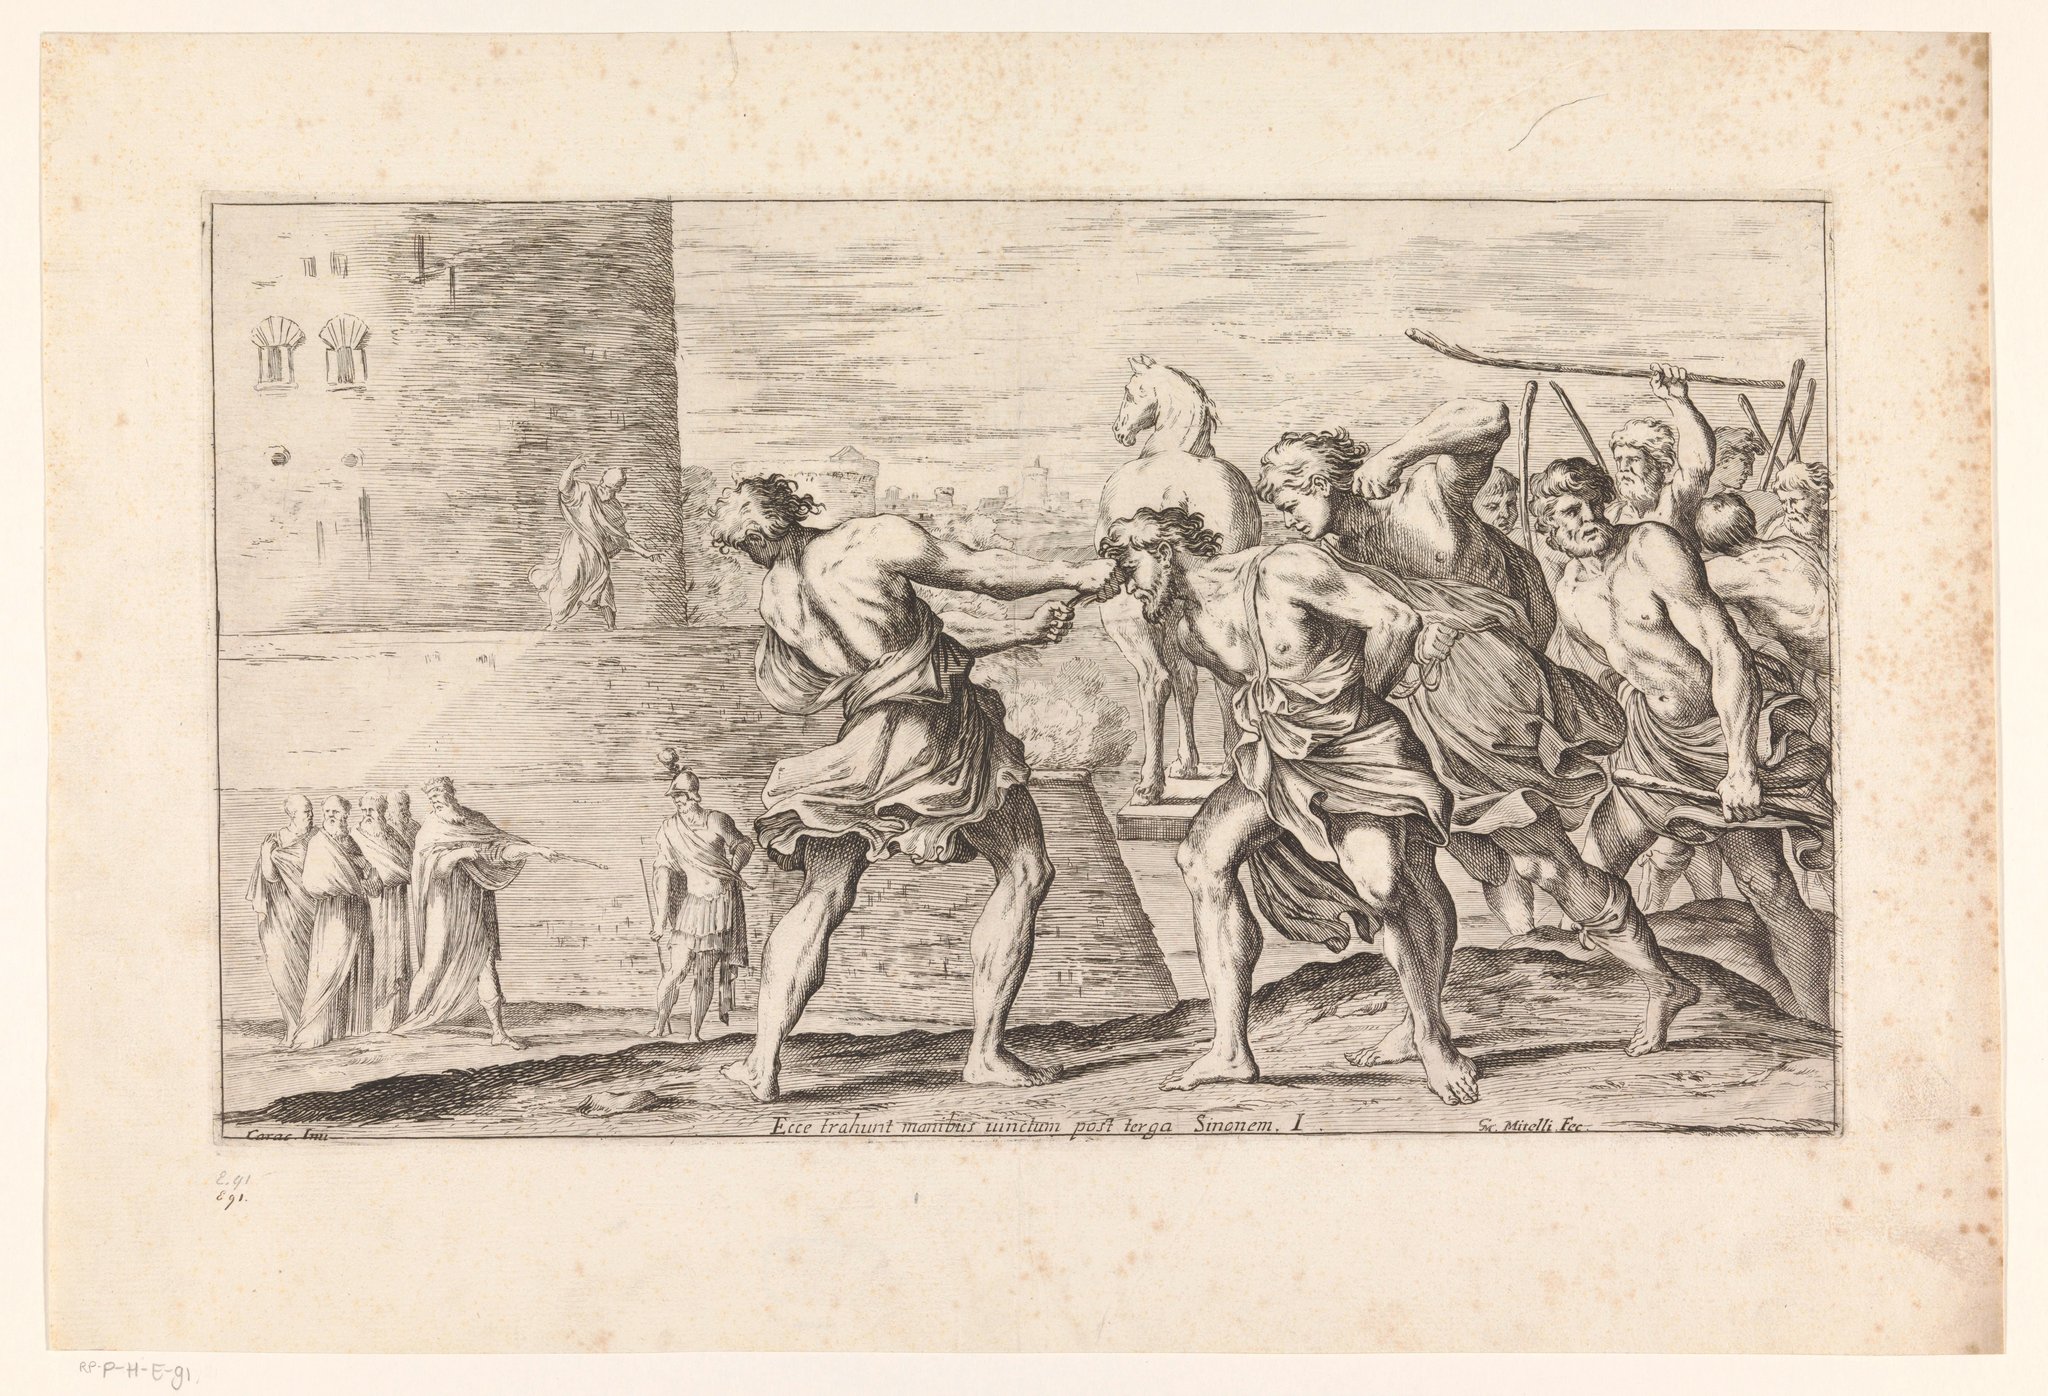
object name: print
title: Omzwervingen van Aeneas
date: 1663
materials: paper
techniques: etching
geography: rome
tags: (story of) aeneas, sinon, a greek pretending to be a deserter, is brought in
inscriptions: collector's mark: ‘Hinloopen’, collector's mark: Lugt 11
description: Deze prent maakt deel uit van een reeks van 20 prenten (+ titelprent) naar de fresco's door de Carracci's in Palazzo Fava Ghisilieri te Bologna. Deze prent maakte oorspronkelijk deel uit van liber nr. 22 van de Atlas van Rome, uit de collectie Hinloopen. In dit album waren een aantal prentreeksen naar bekende zeventiende eeuwse frescoseries bijeengebonden. In 1709 heeft Schijnvoet op last van de burgemeesters van Amsterdam de collectie herordend. De prenten uit liber 22 kwamen terrecht in Schijnvoet boek nr. 10. De laatst gedateerde reeks in het album is gedateerd 1691. Het album moet dus na deze datum gebonden zijn. De band is in de Rijksakademietijd uit elkaar gehaald. De marges van de prenten zijn bij het opbergen in het Rijksprentenkabinet vaak drastisch afgesneden. Van een aantal series waren de prenten teruggeslagen om in het album te passen. (Zie: Waals, Jan van der. De prentschat van Michiel Hinloopen. 's-Gravenhage: SDU uitgeverij, 1988, pp. 173-174.)